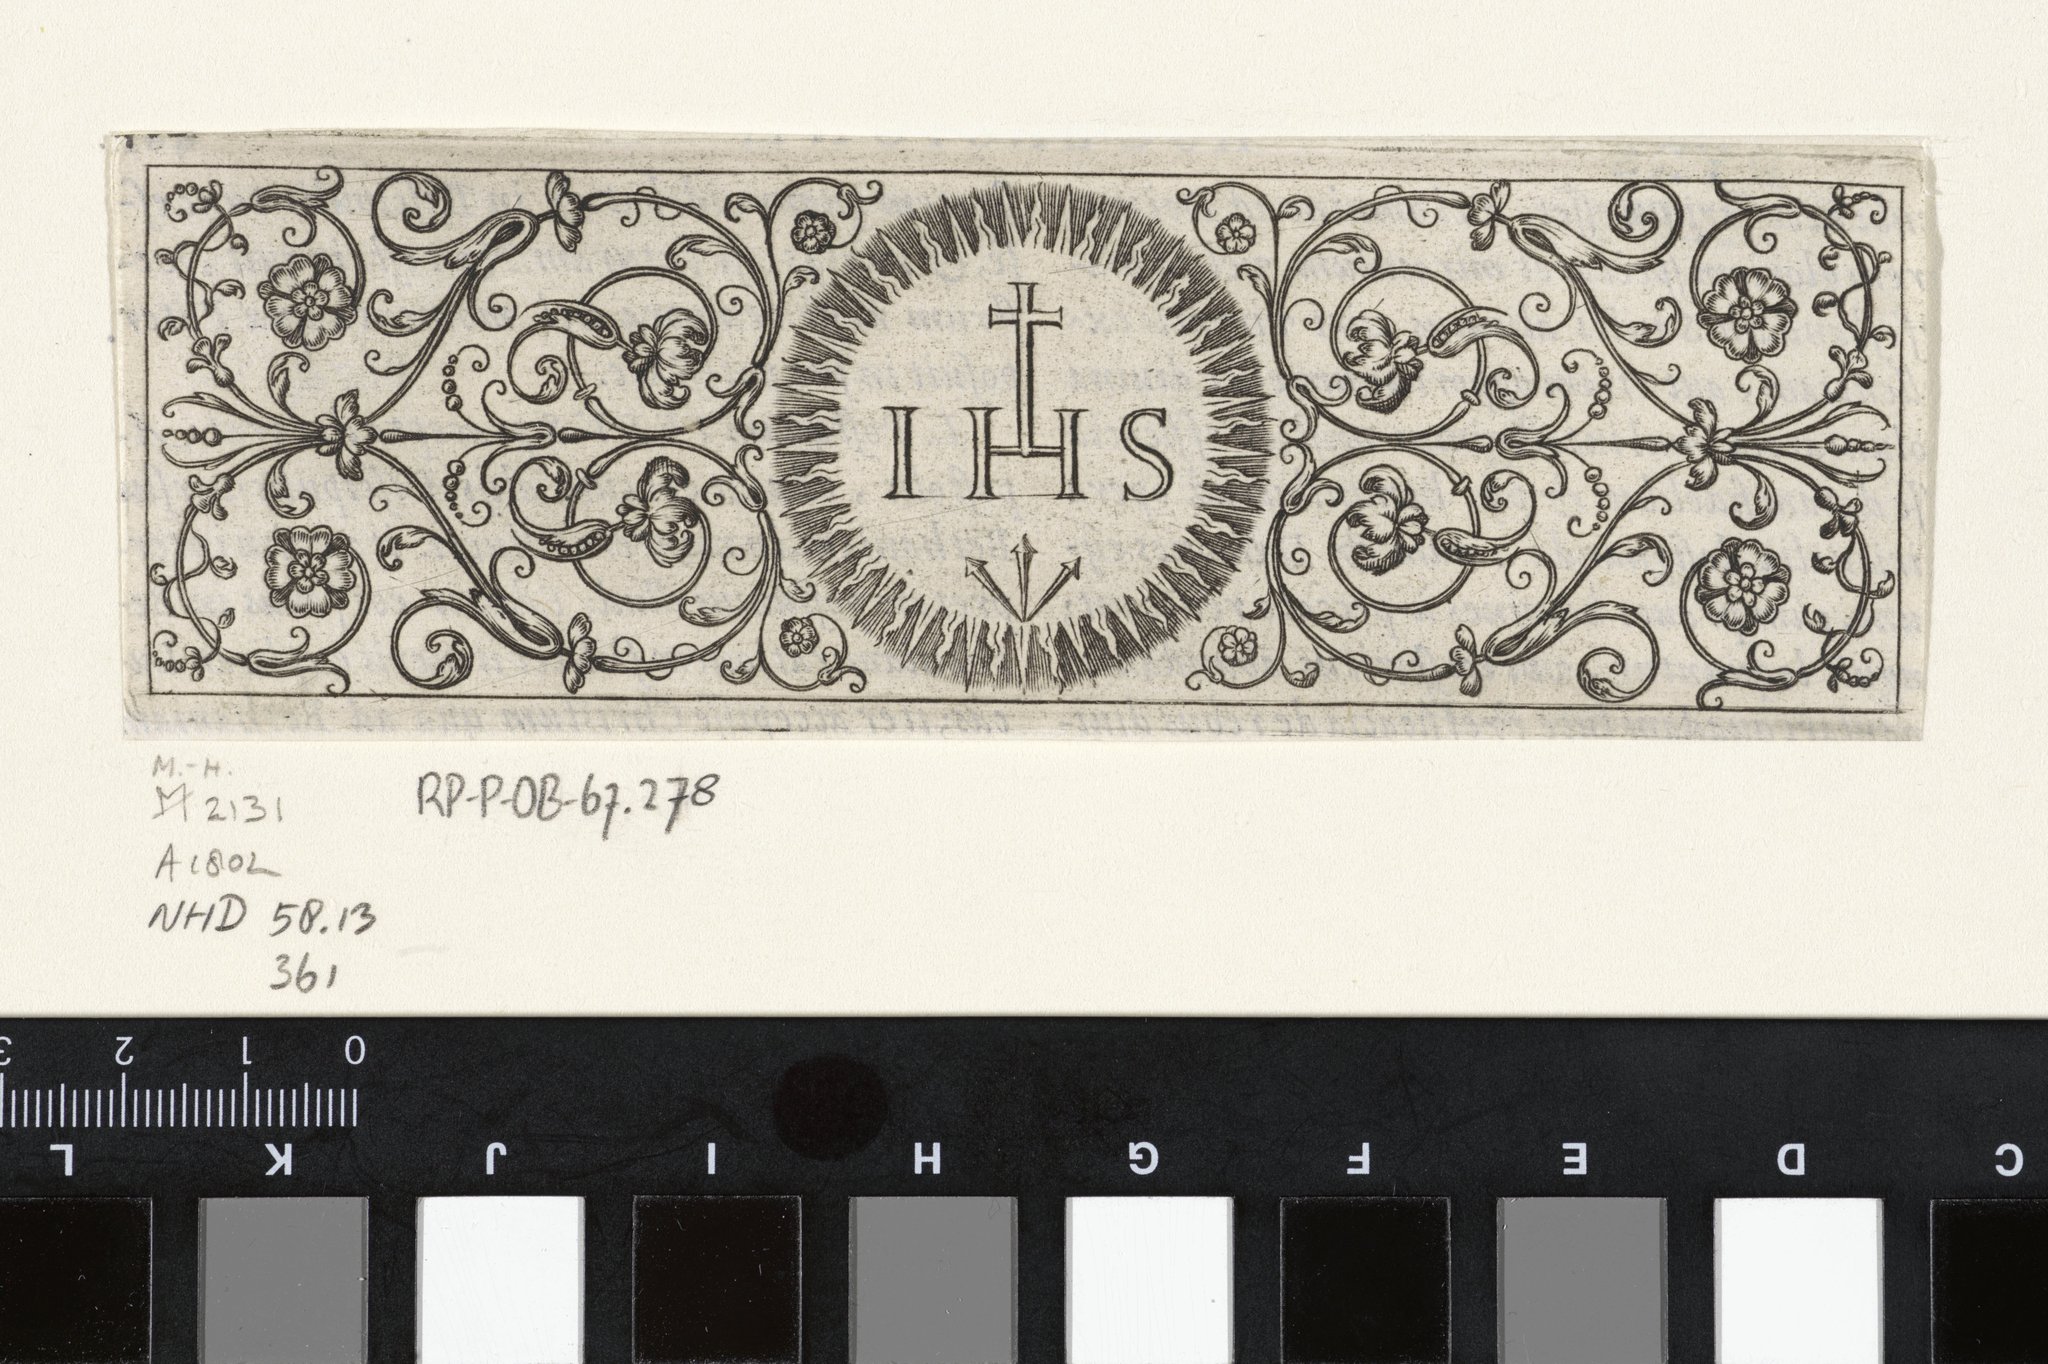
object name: book illustration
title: Ornament met het monogram van Christus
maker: wierix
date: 1594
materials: paper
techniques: engraving, letterpress printing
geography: antwerp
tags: ihs ('iesus hominum salvator') ~ symbol of christ, flowers ~ ornament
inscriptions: collector's mark: Lugt 2165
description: Prent gebruikt in: Nadal, Jerónimo. Adnotationes et Meditationes. Antwerpen: Martinus Nutius, 1594.